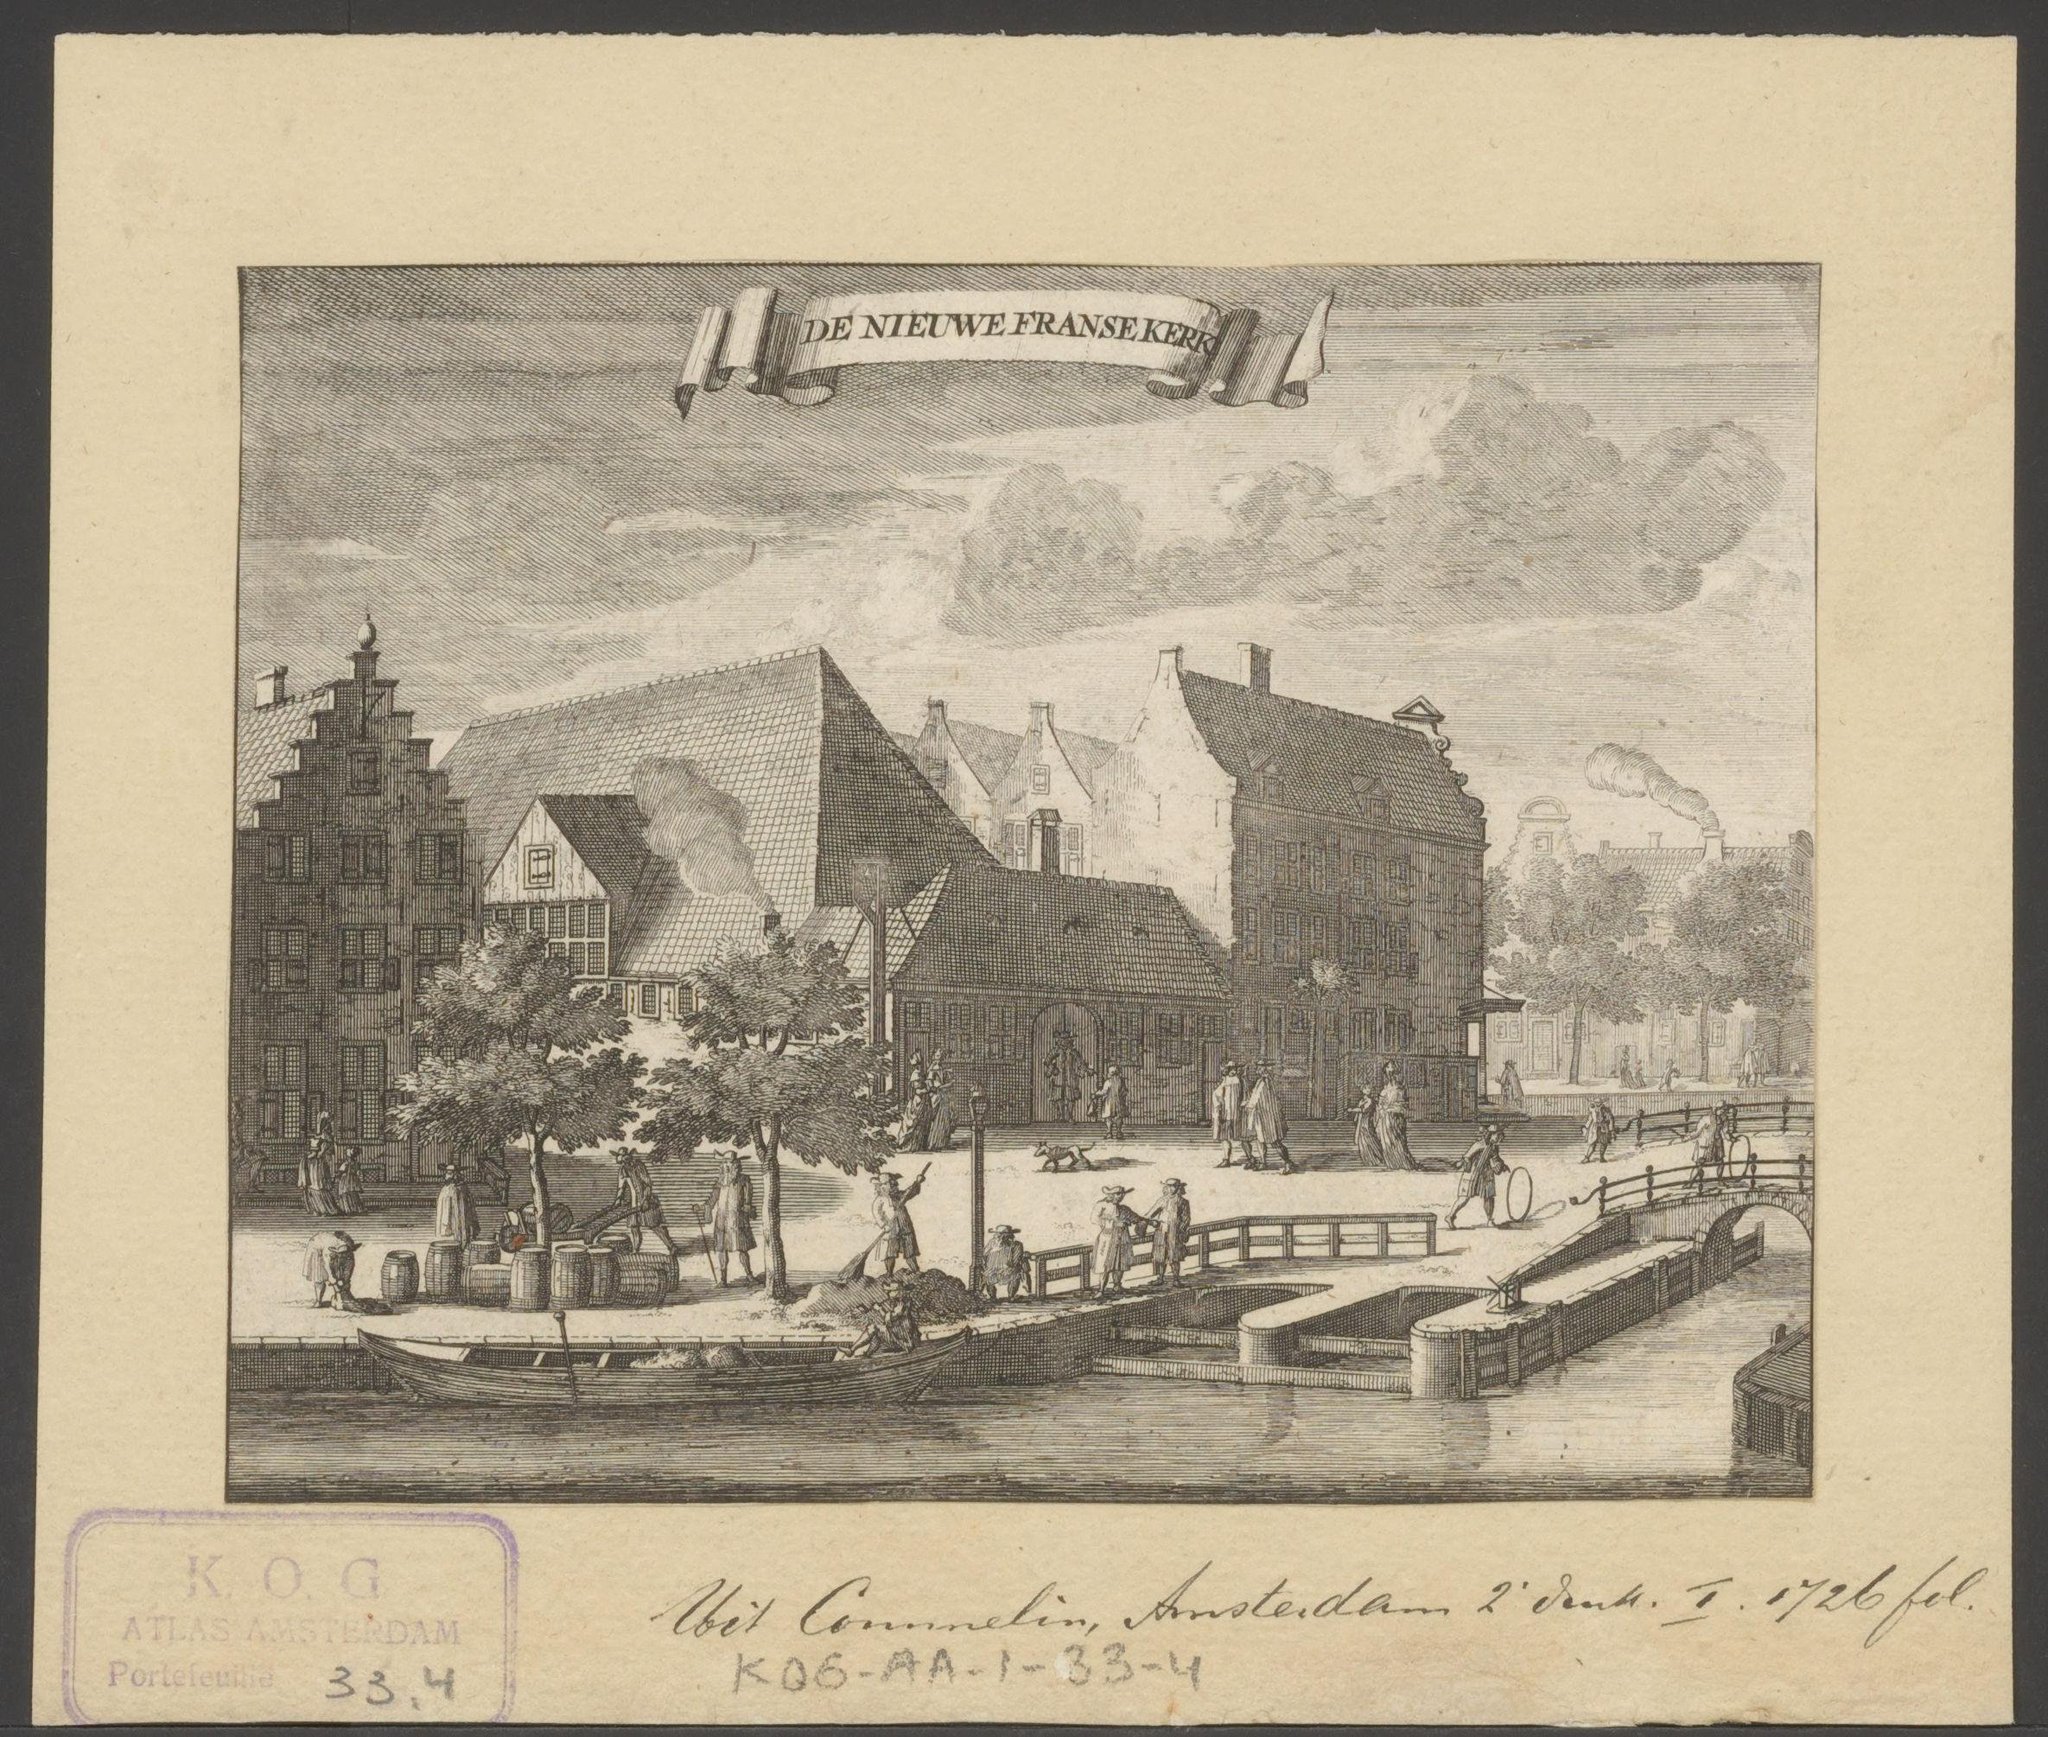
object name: print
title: Gezicht op de Nieuwe Waalse Kerk te Amsterdam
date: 1726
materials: paper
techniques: engraving, etching, letterpress printing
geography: amsterdam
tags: church (exterior), rowing-boat, canoe, etc., canals, waters (in city) (+ city(-scape) with figures, staffage)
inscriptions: collector's mark: Lugt 1641b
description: Prent uit: Commelin, Casparus. Beschryvinge van Amsterdam (…). 2de druk. Amsterdam: Andries van Damme, Johannes Ratelband, weduwe Antony van Aeltwijk en Hermanus Uytwerf, 1726, dl. 1, p. 482.